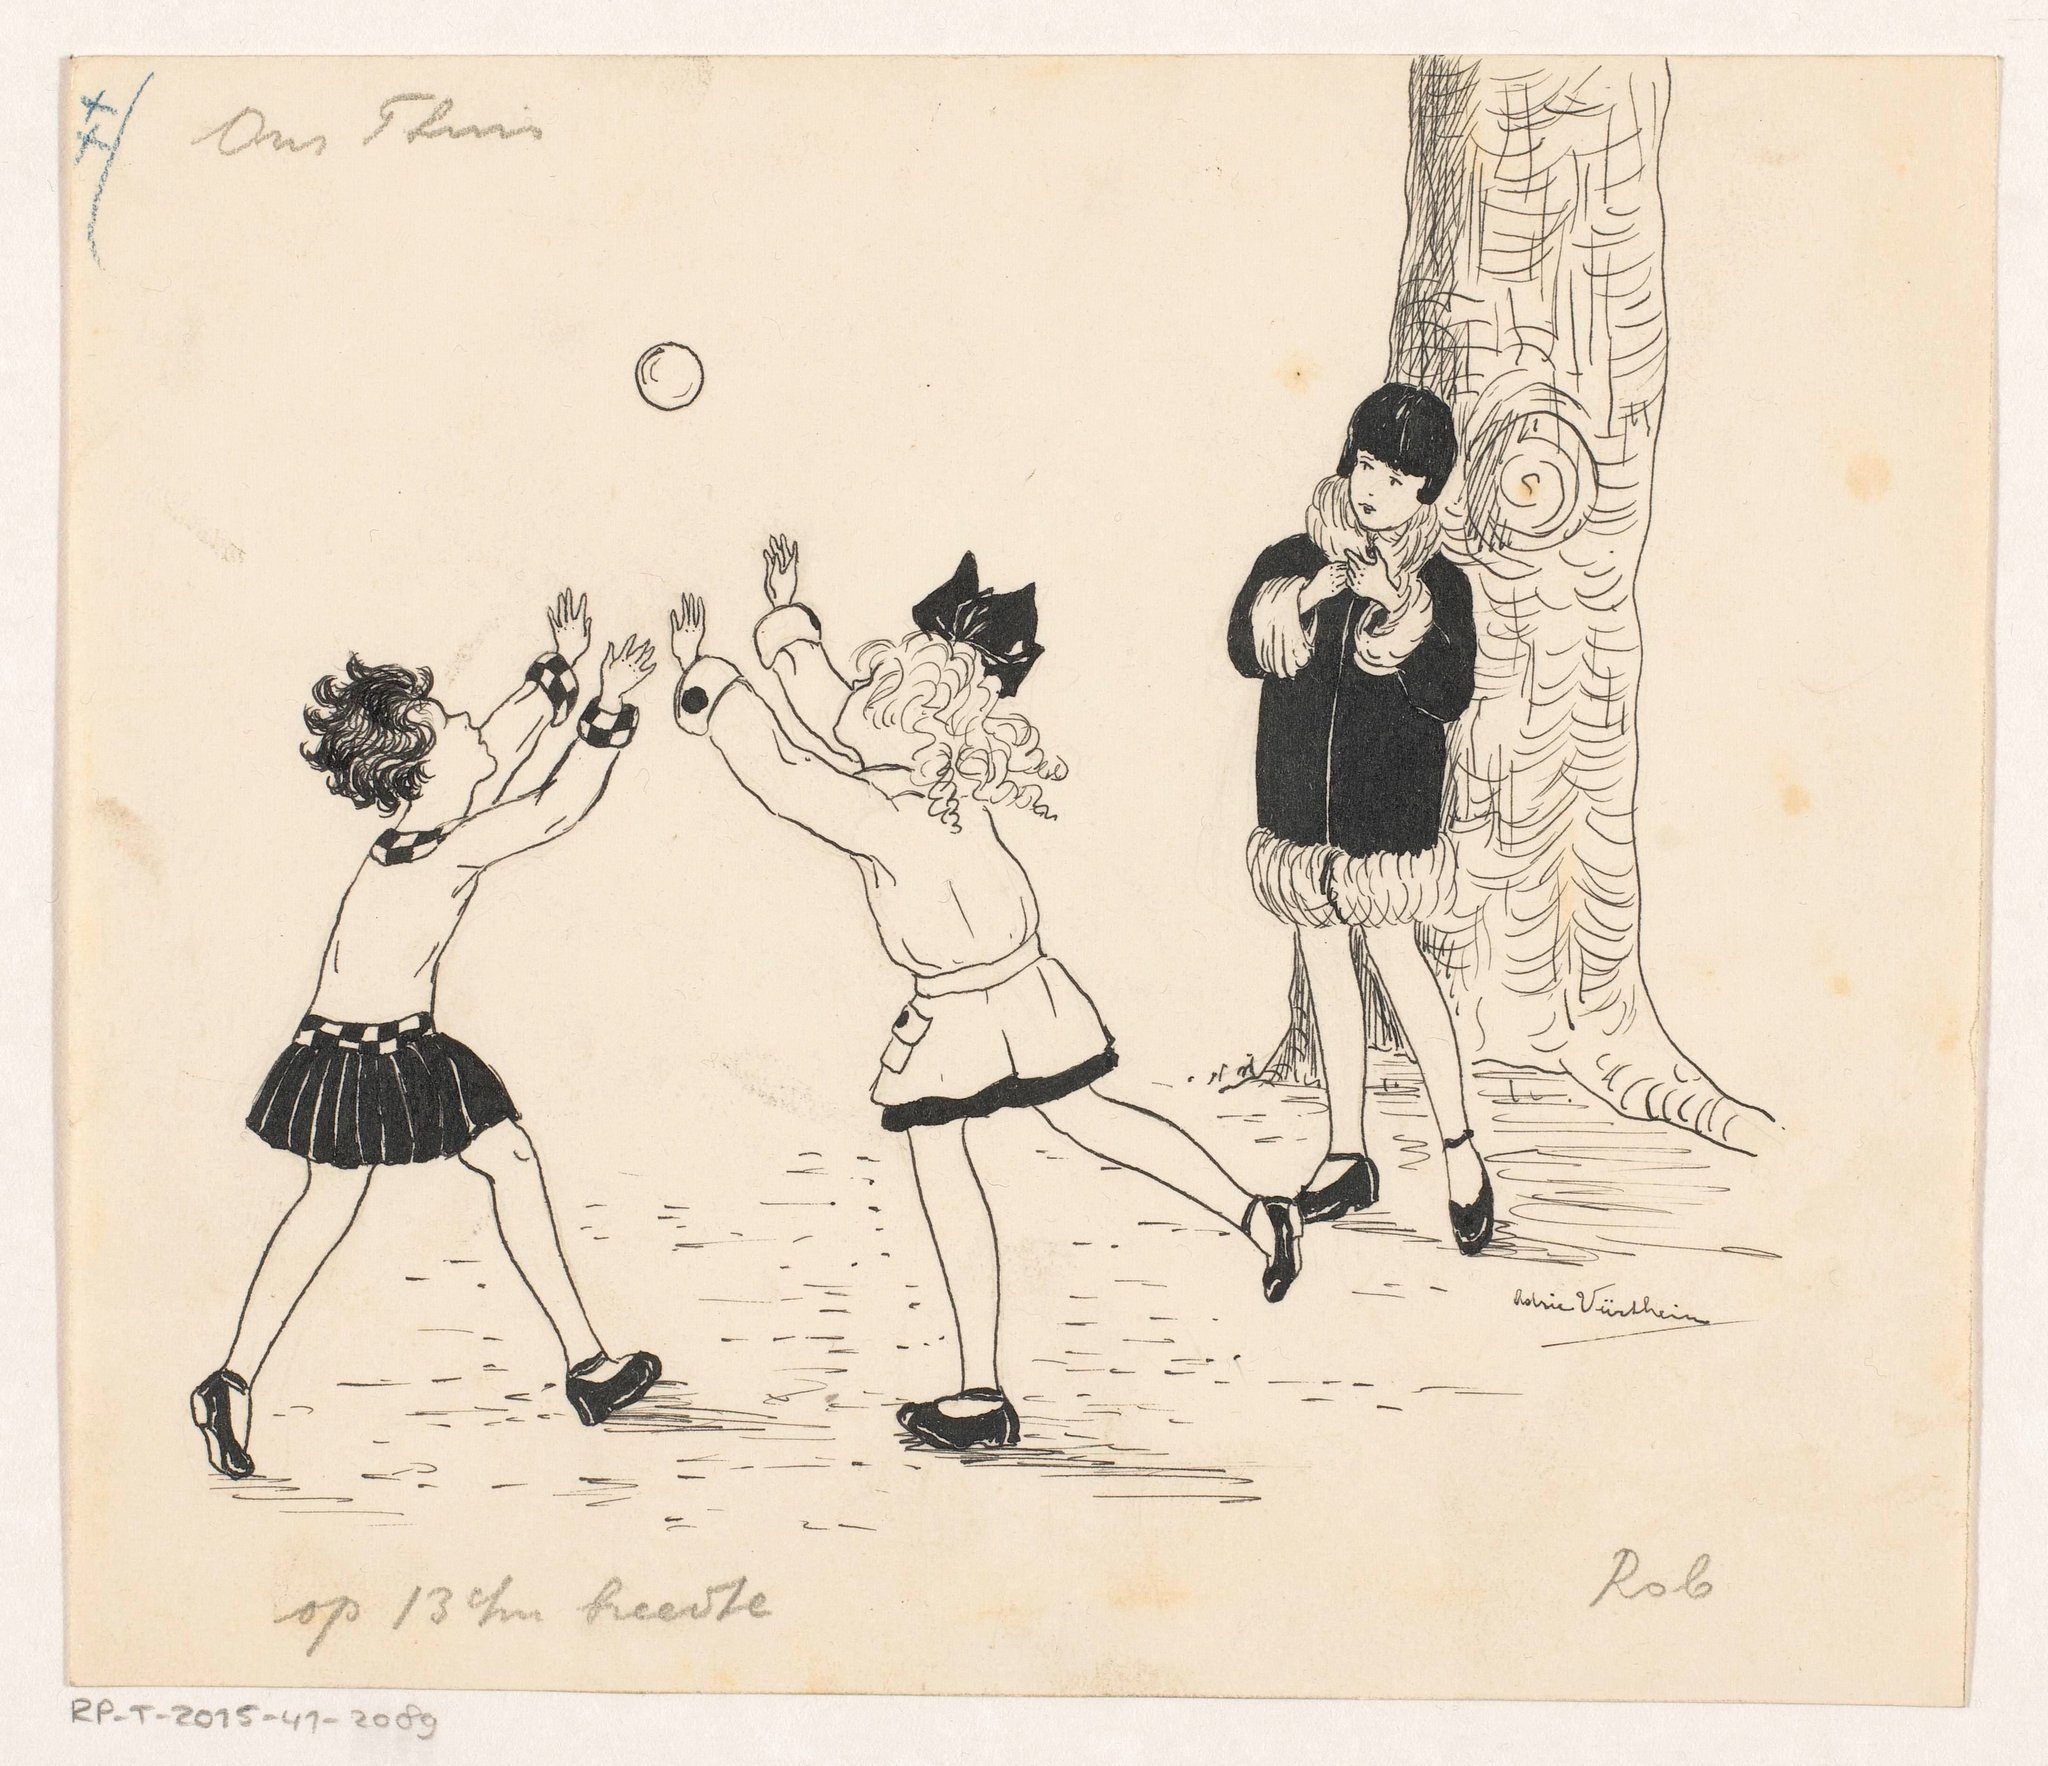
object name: drawing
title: Meisjes spelen met bal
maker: adrie vürtheim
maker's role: draughtsman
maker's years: 1907-1995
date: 1925-1935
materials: ink, paper, pencil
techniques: brush, pen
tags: ball games (children's games)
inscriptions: :, signature: ‘Adrie Vürtheim’, annotation: ‘Ons Thuis/ Rol’, collector's mark: Lugt 2228a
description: Twee meisjes houden hun handen uitgestrekt om een bal te vangen die in de lucht hangt. Een derde meisje, gekleed in een met bont afgezette jas, staat bij een boom toe te kijken.